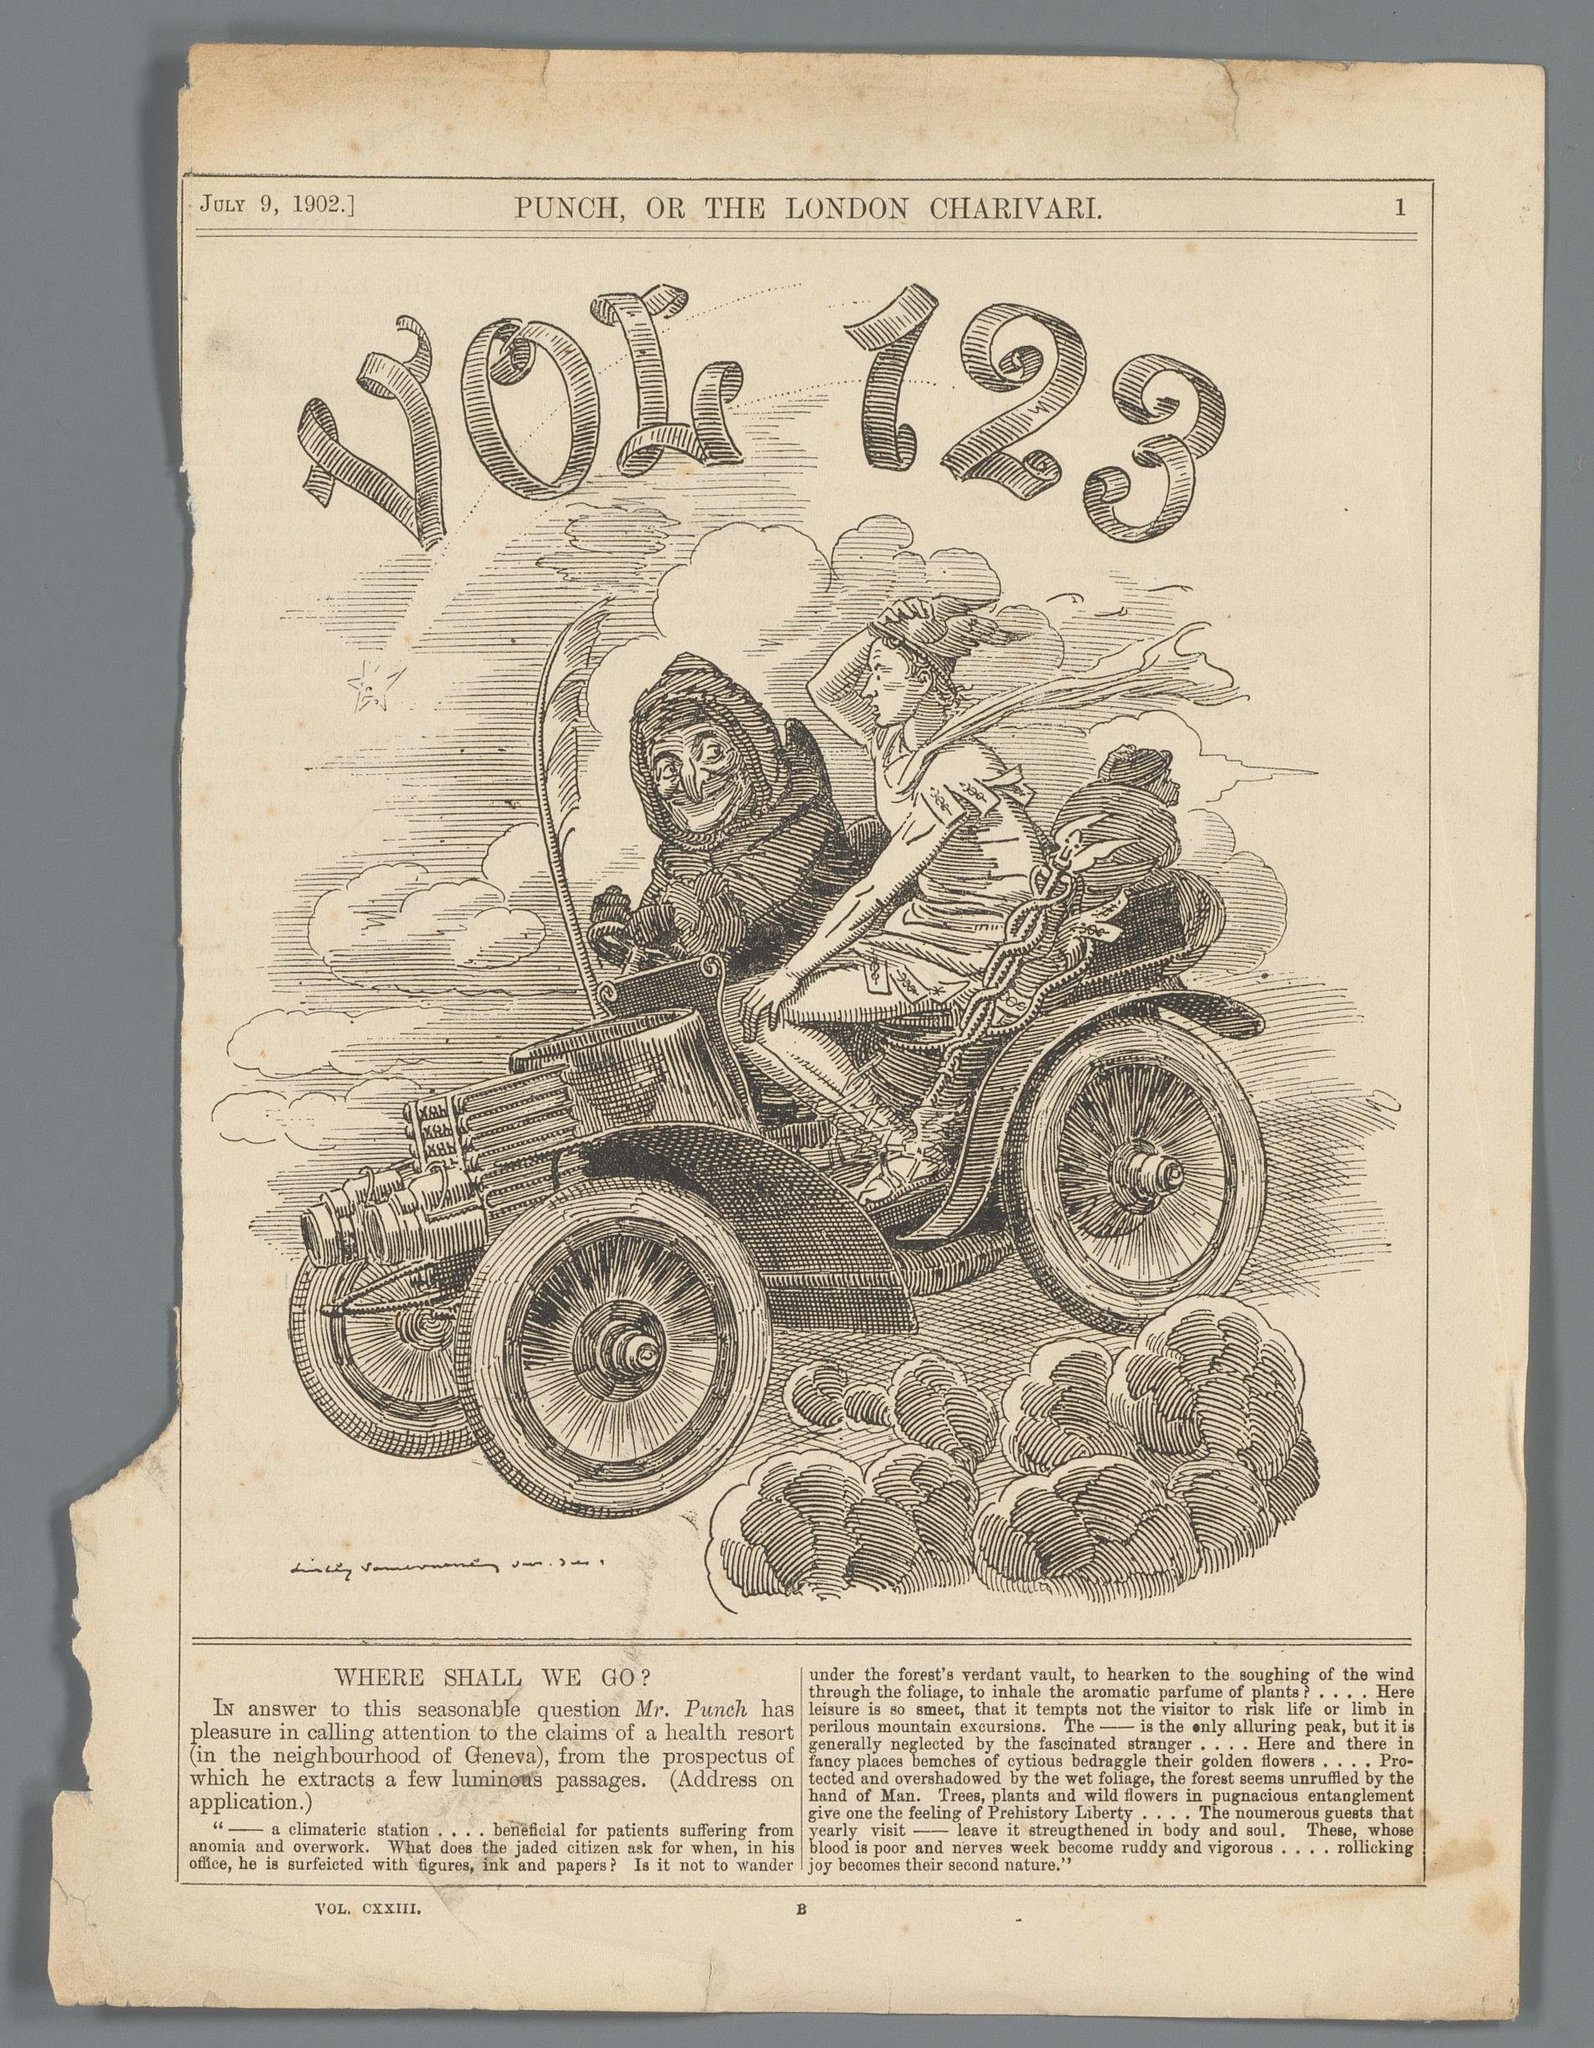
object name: print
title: Vignet voor Punch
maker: edward linley sambourne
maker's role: draughtsman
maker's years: 1844-1910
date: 1902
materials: paper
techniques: line block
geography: england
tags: (story of) mercury (hermes), automobile, political caricatures and satires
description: Mr. Punch rijdt met Mercurius in een auto door de wolken. Vignet voor vol. 123 van het Engelse satirische tijdschrift Punch, 9 juli 1902.